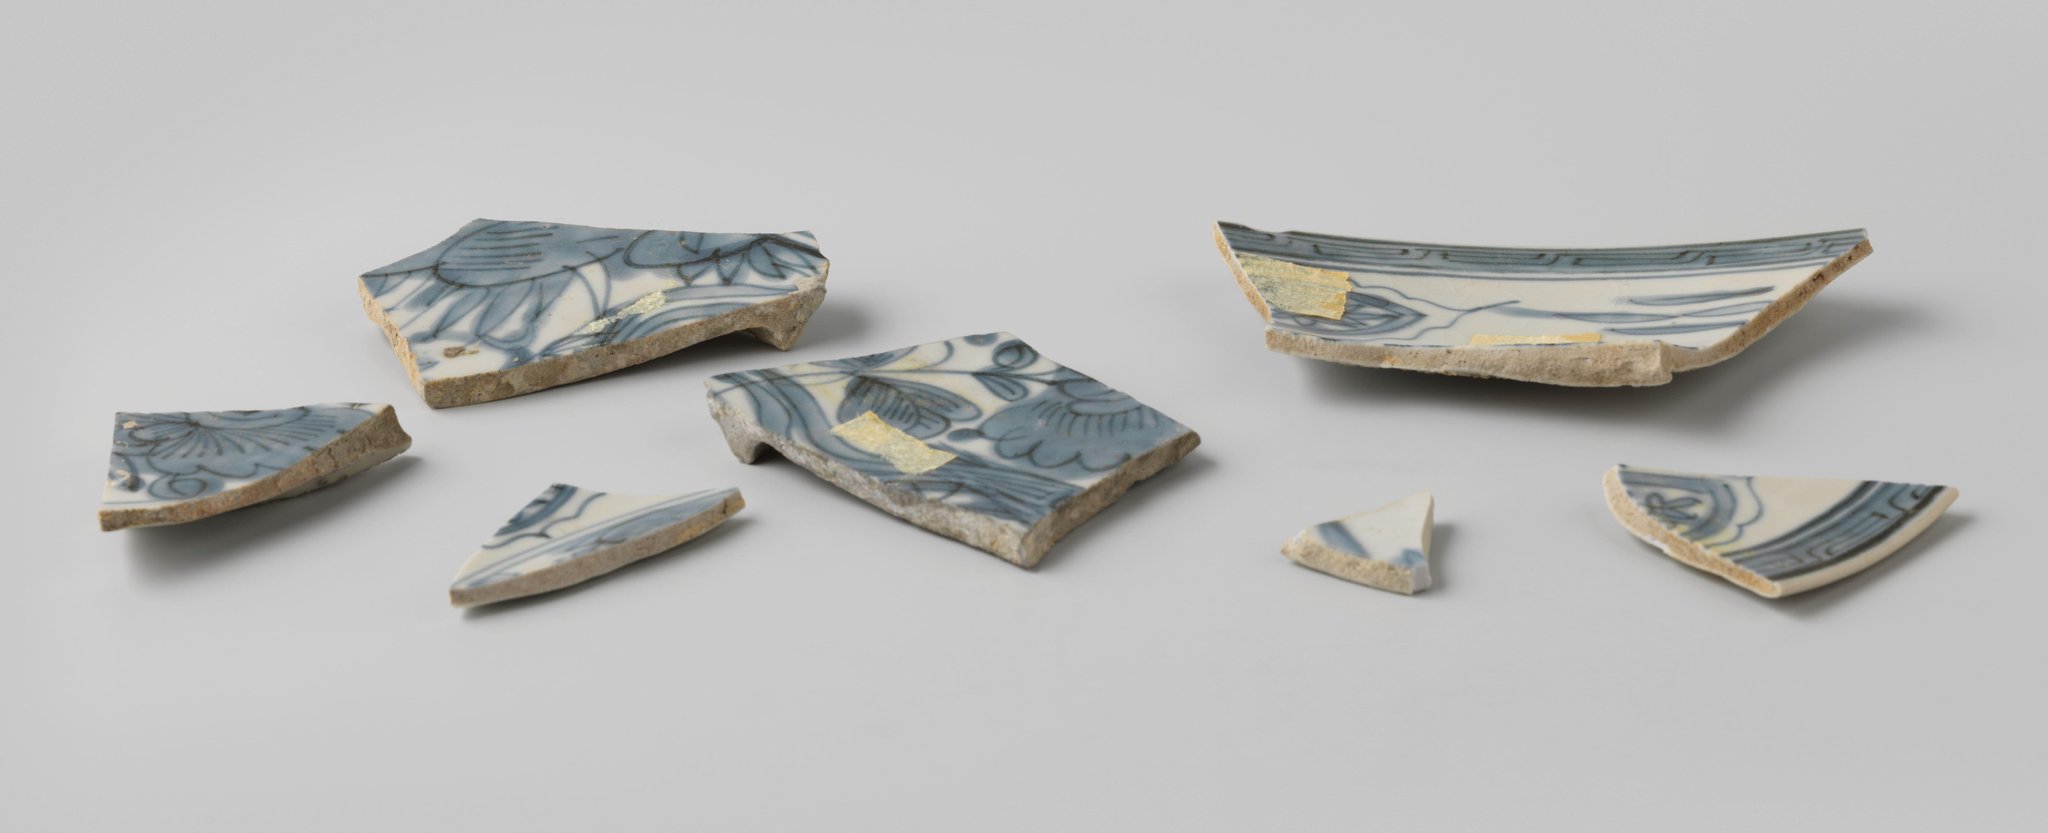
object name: plate dish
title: Scherven van een bord uit V.O.C.-schip de 'Witte Leeuw'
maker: Anonymous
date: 1613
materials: porcelain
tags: verenigde oostindische compagnie, sint-helena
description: Scherven van een bord uit V.O.C.-schip de 'Witte Leeuw'.